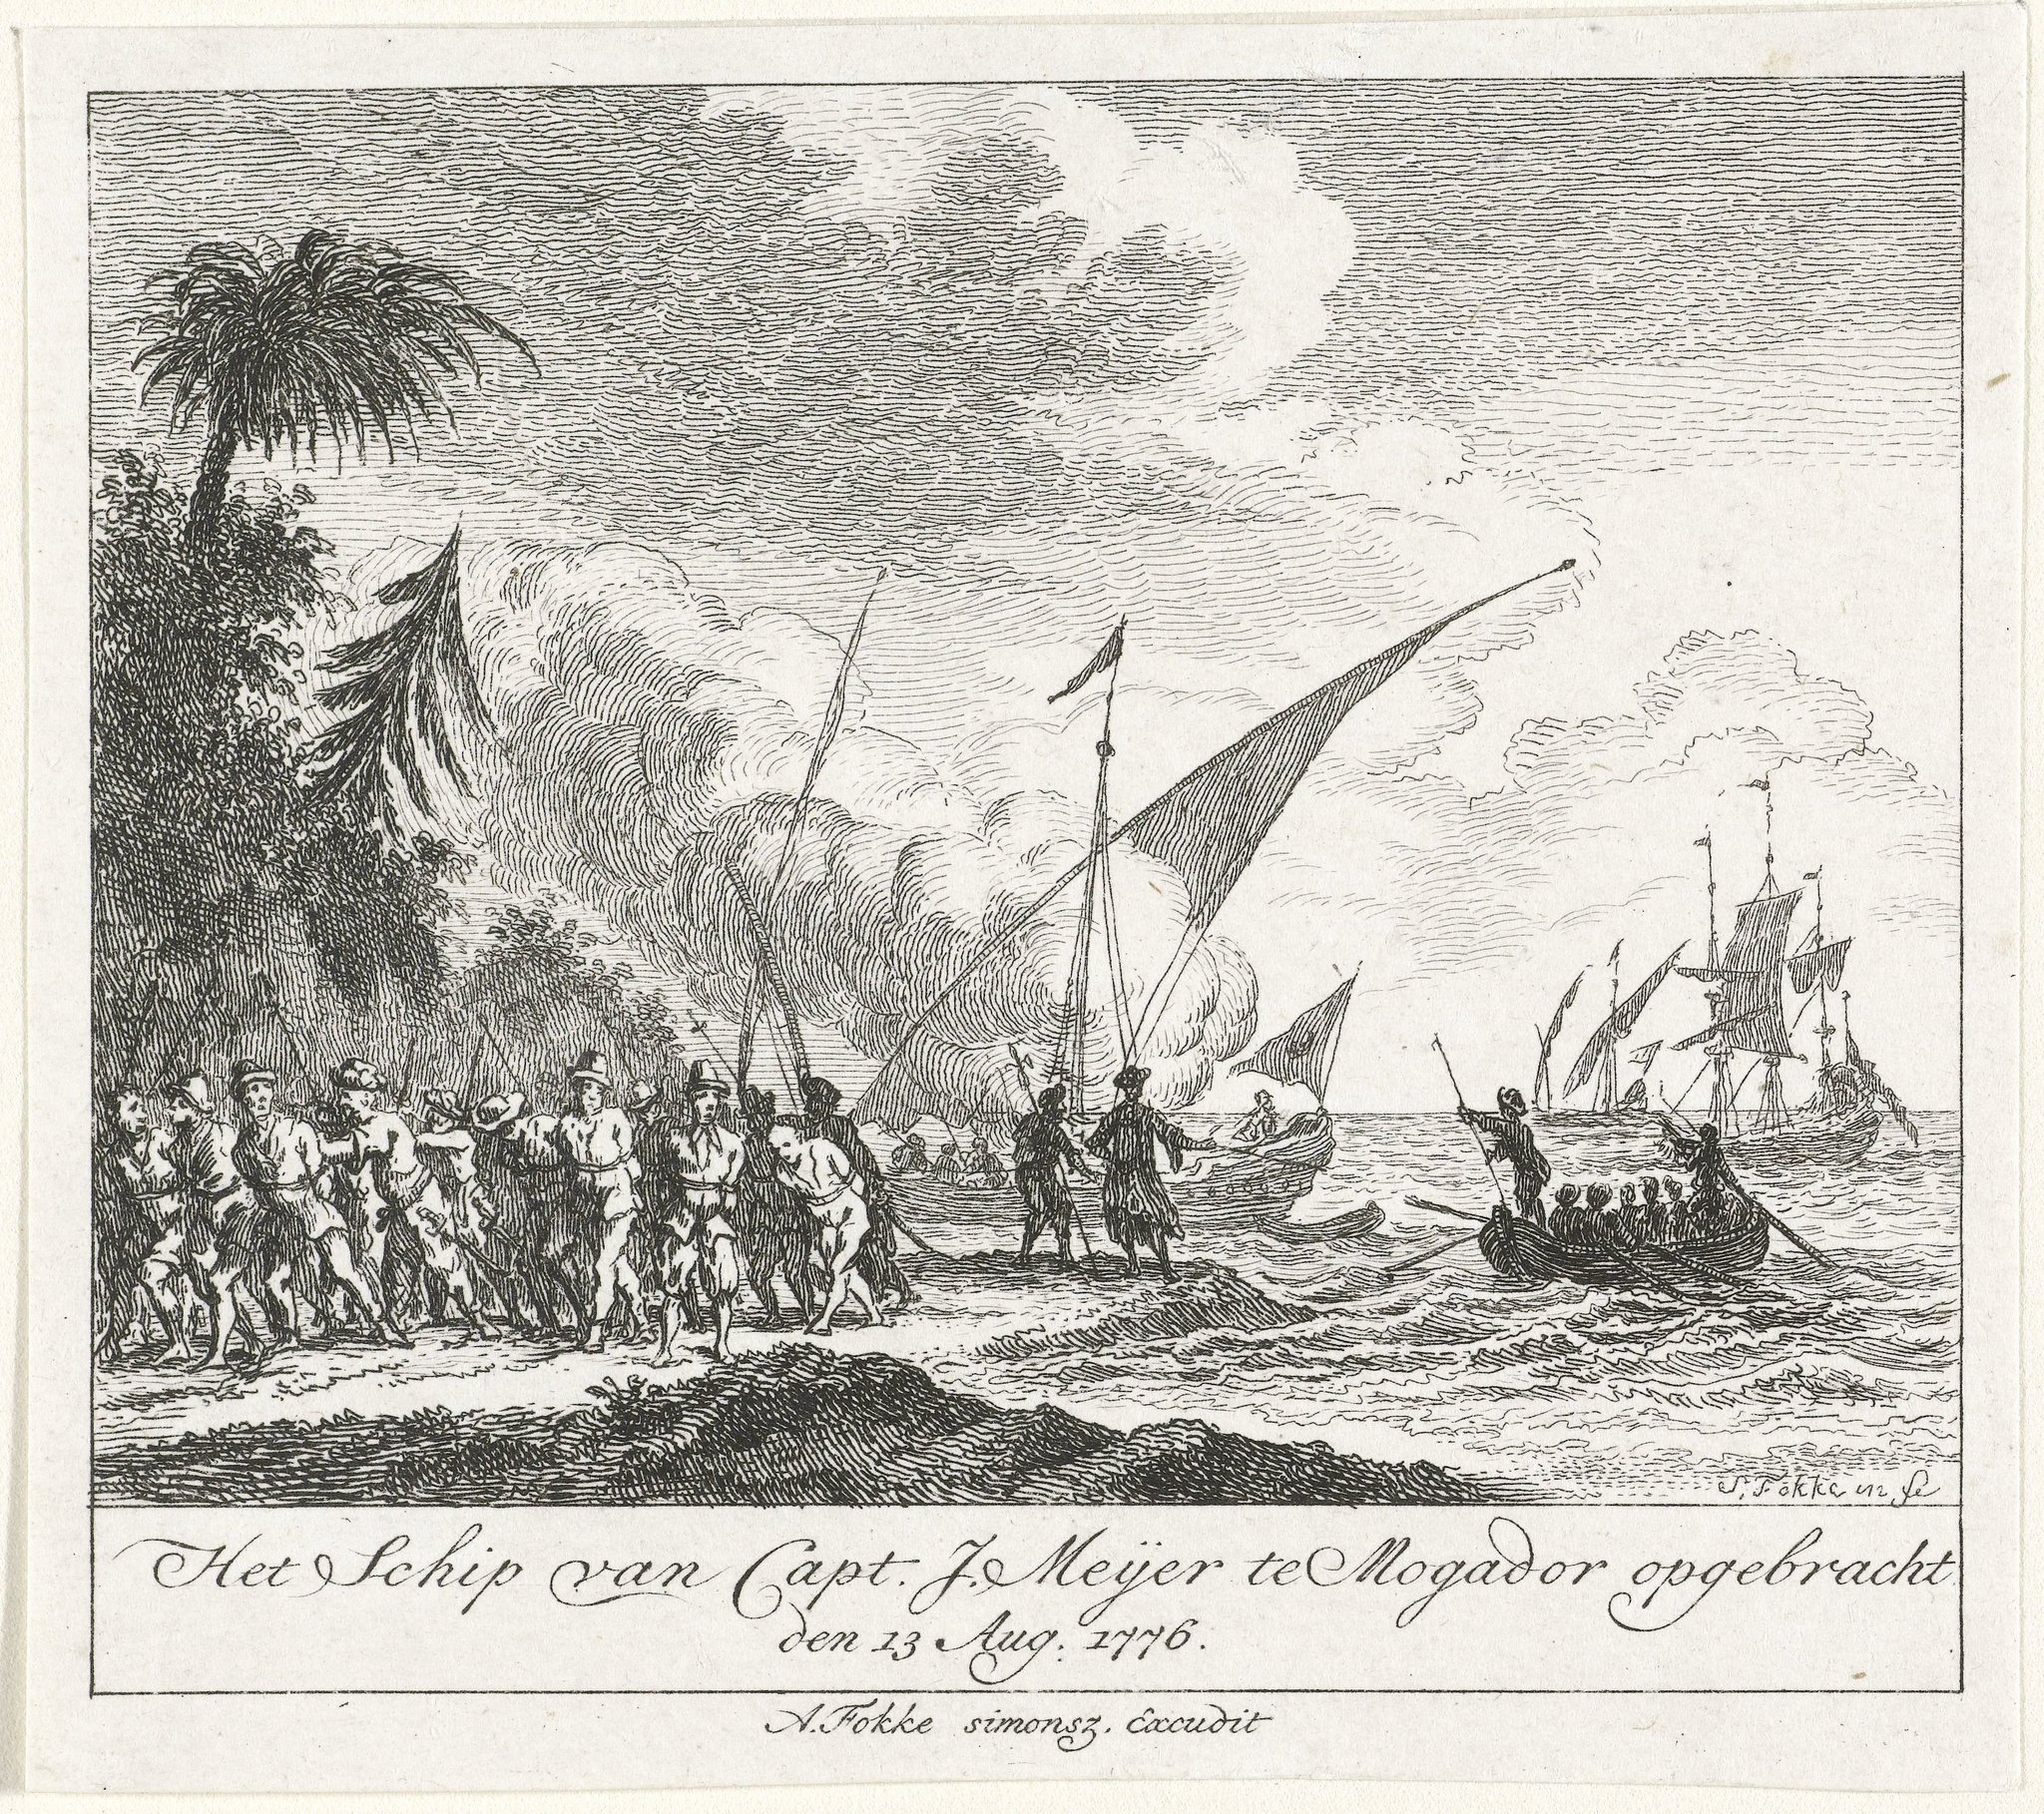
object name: print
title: Het Schip van Capt. J. Meijer te Mogador opgebracht den 13 Aug. 1776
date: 1776-1784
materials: paper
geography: amsterdam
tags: battle (+ naval force), hostage (after the battle) (+ naval force)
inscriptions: collector's mark: Lugt 2228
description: Voorstelling uit de vaderlandse geschiedenis. Opvarenden van het schip van kapitein J. Meijer zijn voor de kust van Marokko gevangengenomen en worden vastgebonden het land opgedreven. In de verte ligt het in beslag genomen schip.